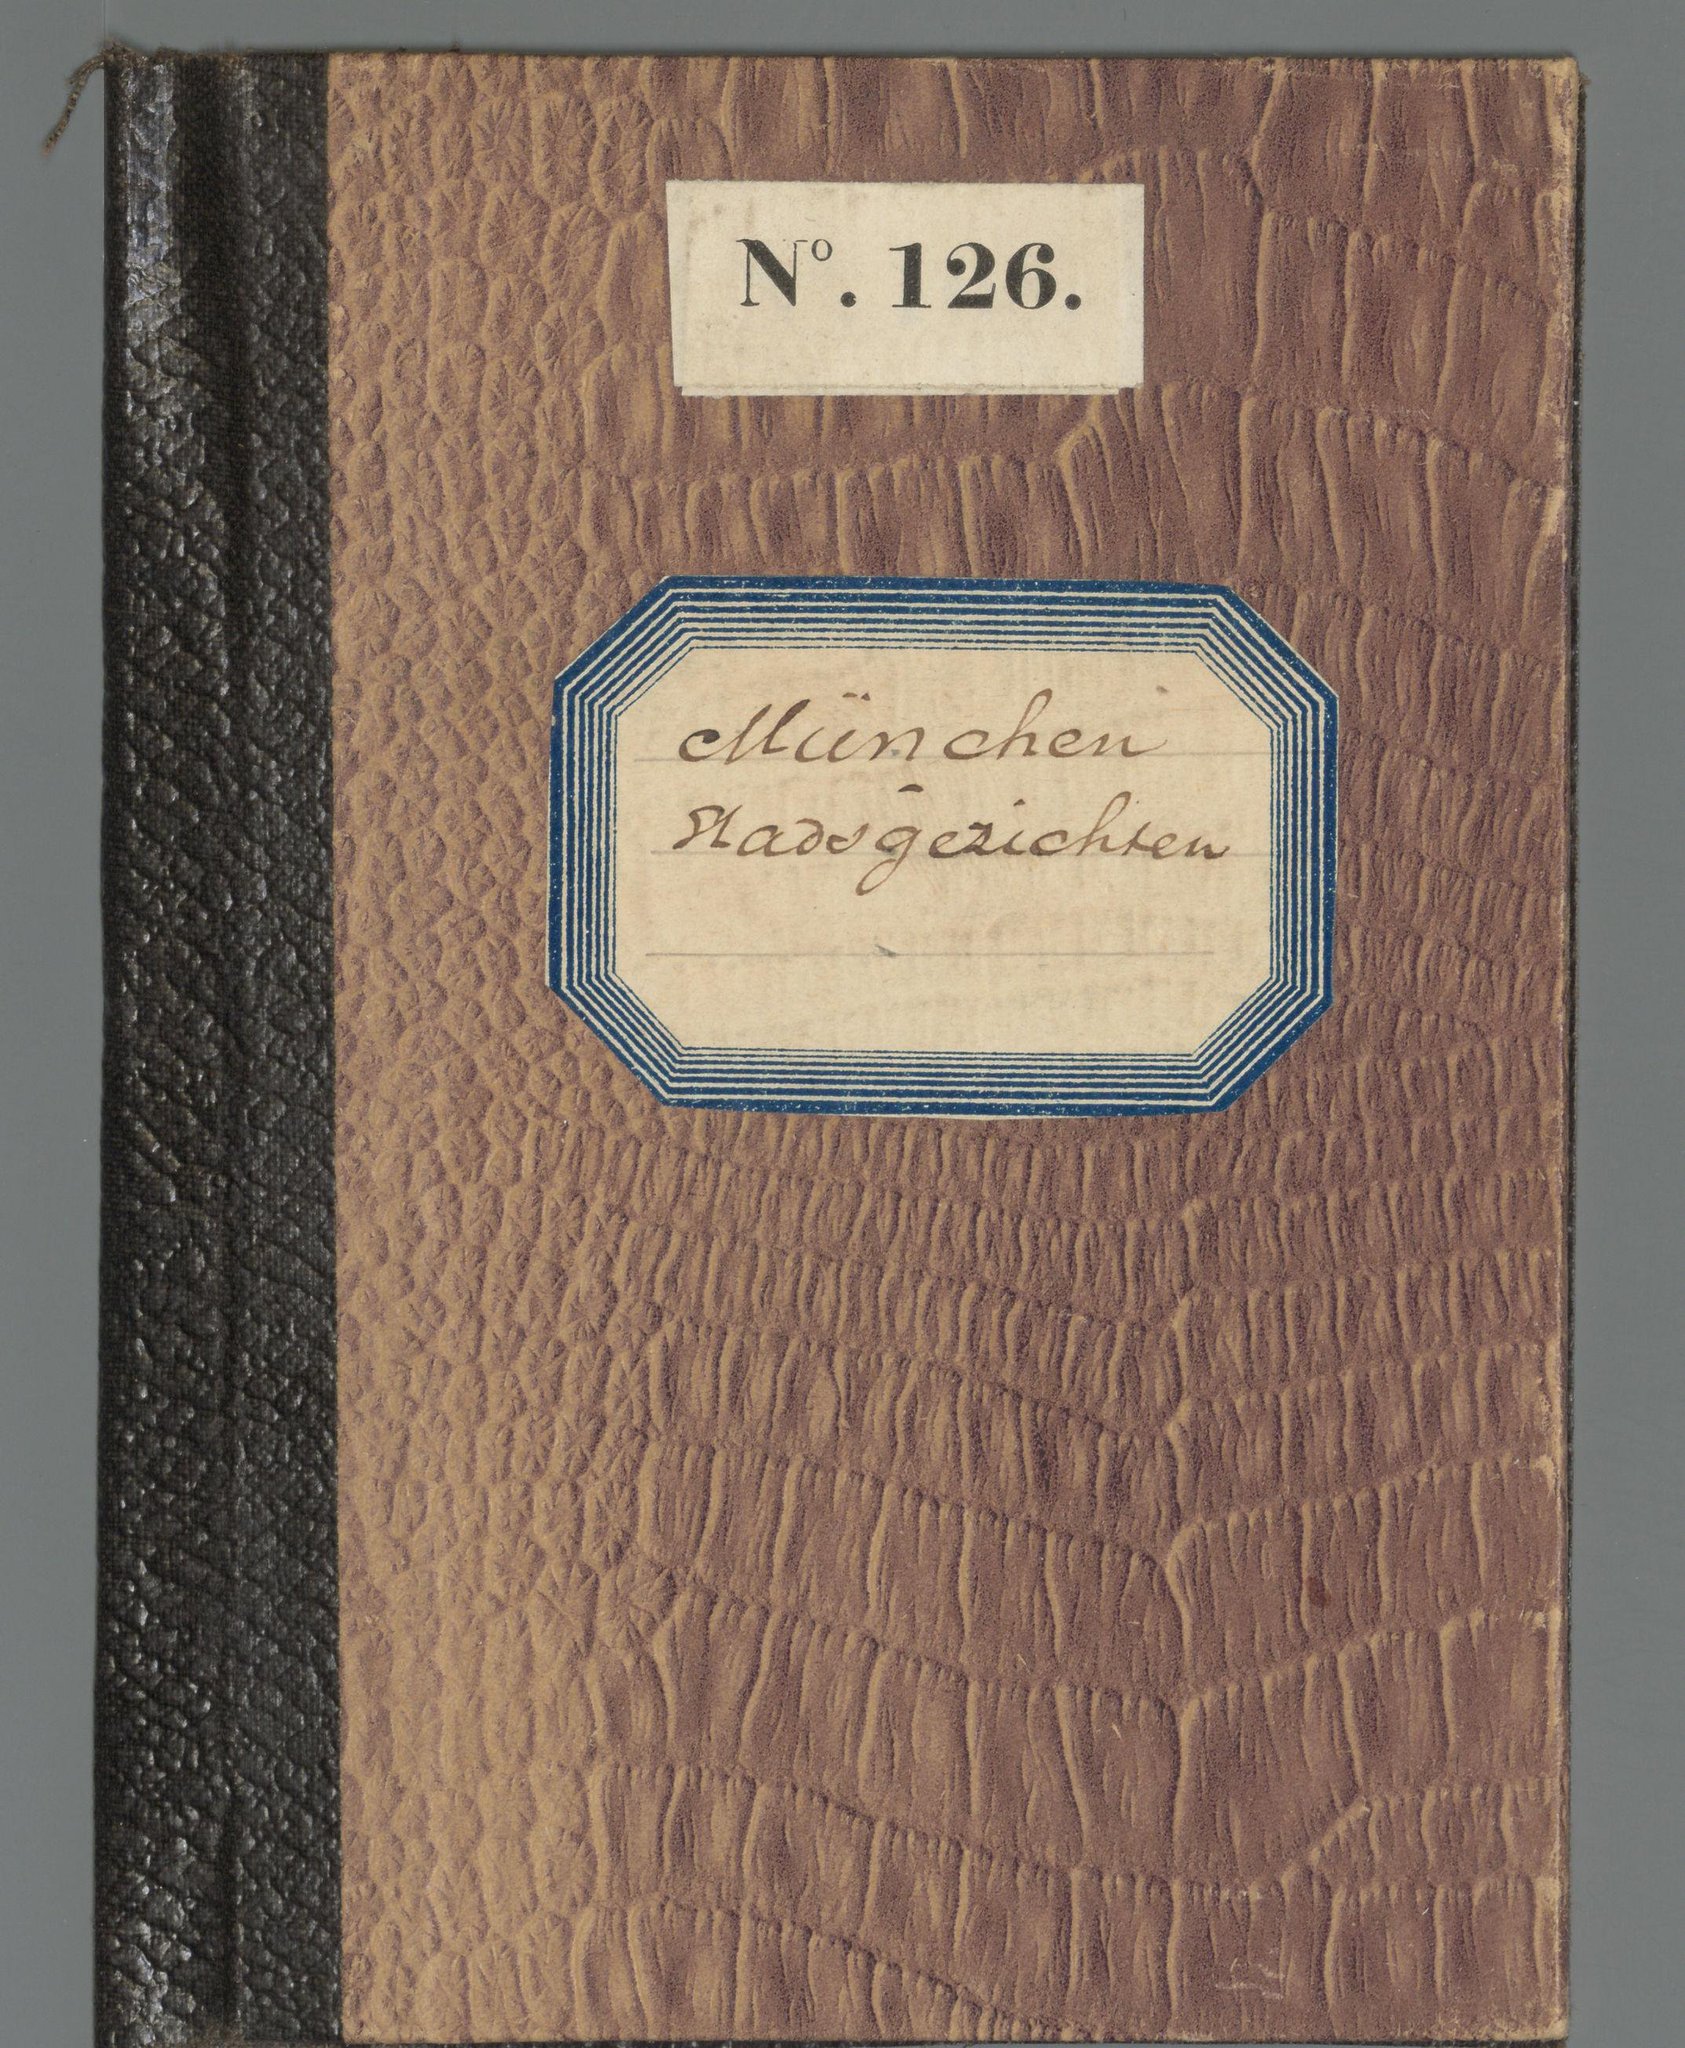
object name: wrapper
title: München. Monumenten. National Museum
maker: Anonymous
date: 1900-1950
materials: cardboard, paper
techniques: lithograph, writing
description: In de omslag zit een kaart ingestoken met daarop een korte beschrijving van de inhoud.